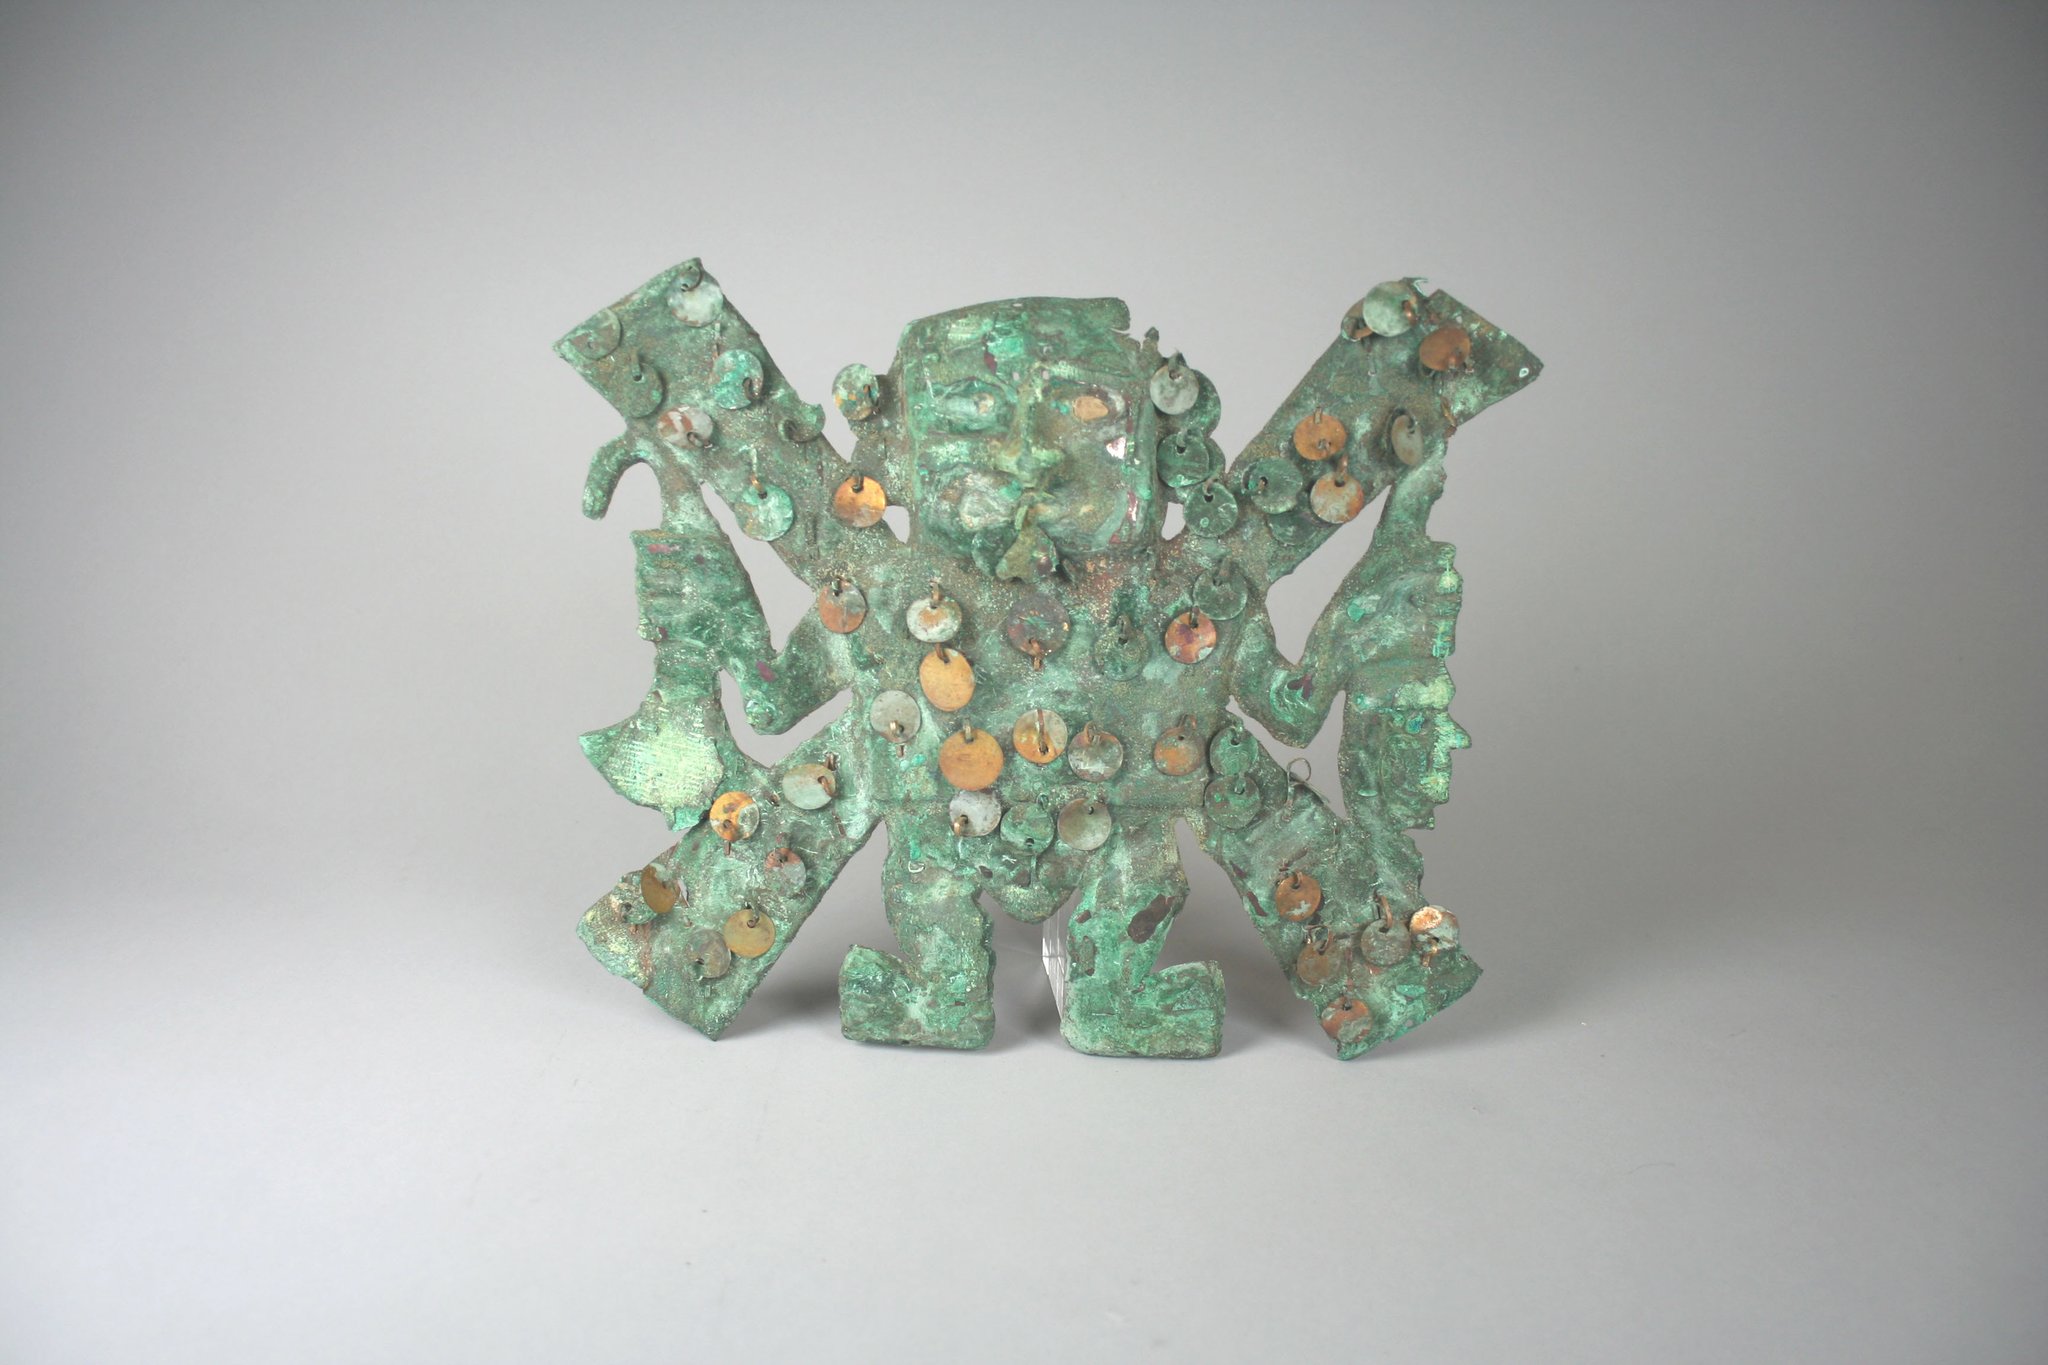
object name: ornament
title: Deity Ornament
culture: moche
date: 501-700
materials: metal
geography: peru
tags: deities